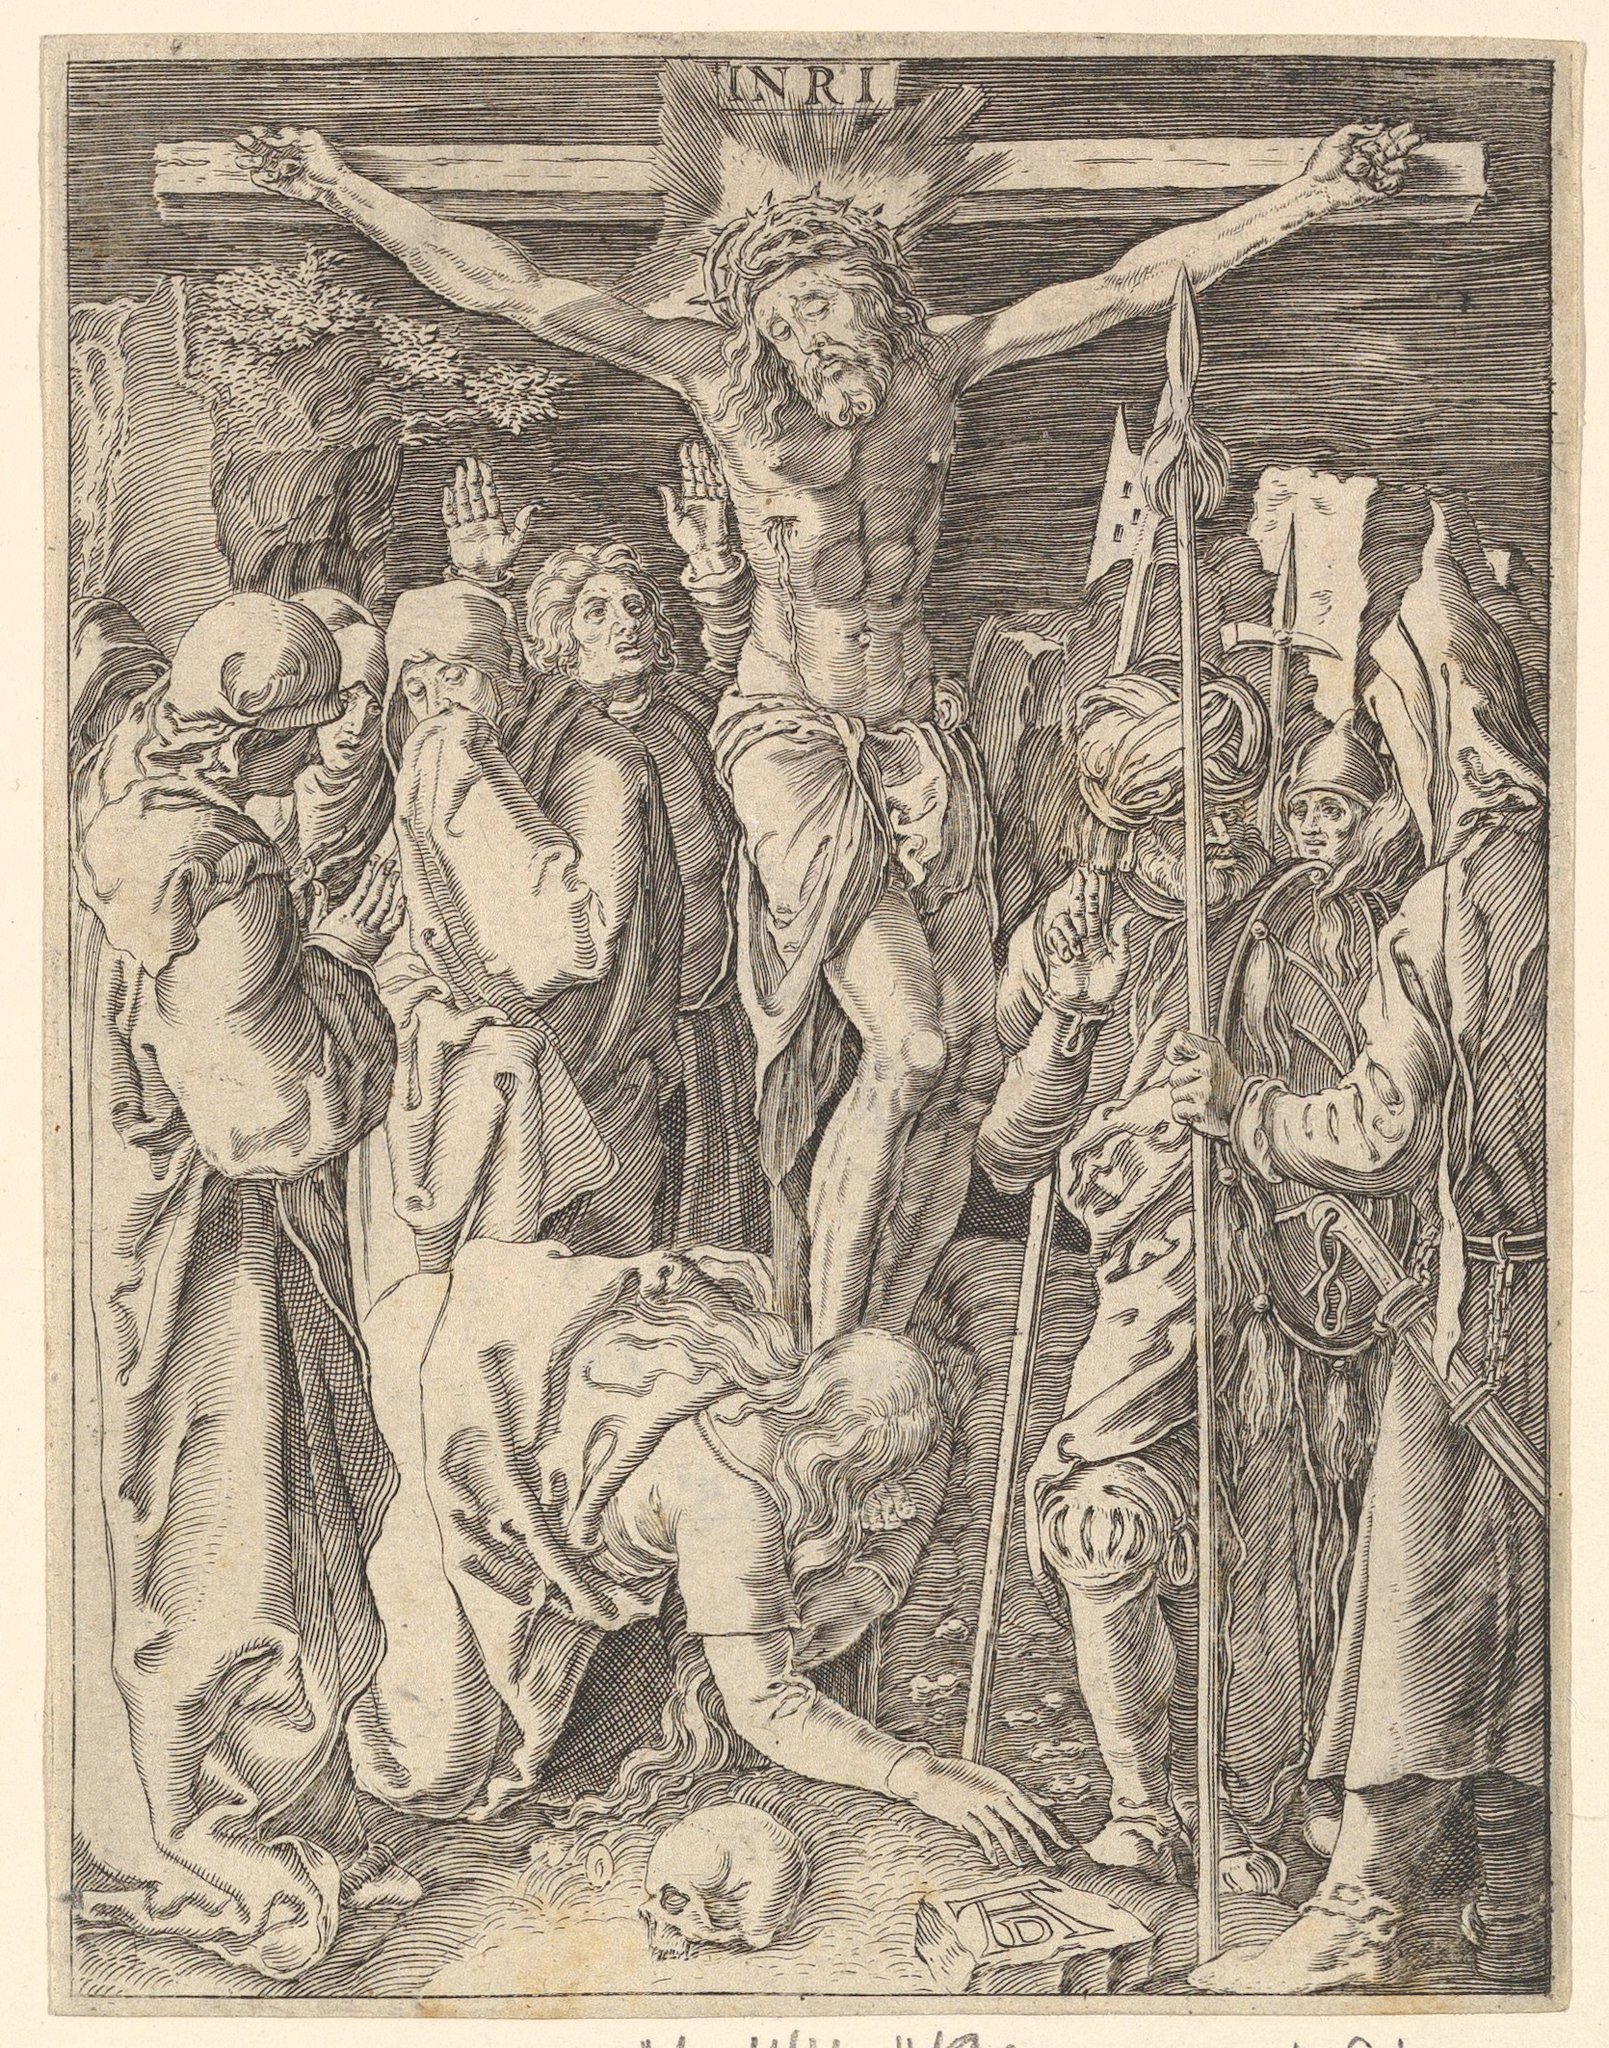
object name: print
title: Engraved copies of The Little Passion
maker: albrecht dürer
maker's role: artist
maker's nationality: german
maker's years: 1471-1528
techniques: engraving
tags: christ,crucifixion